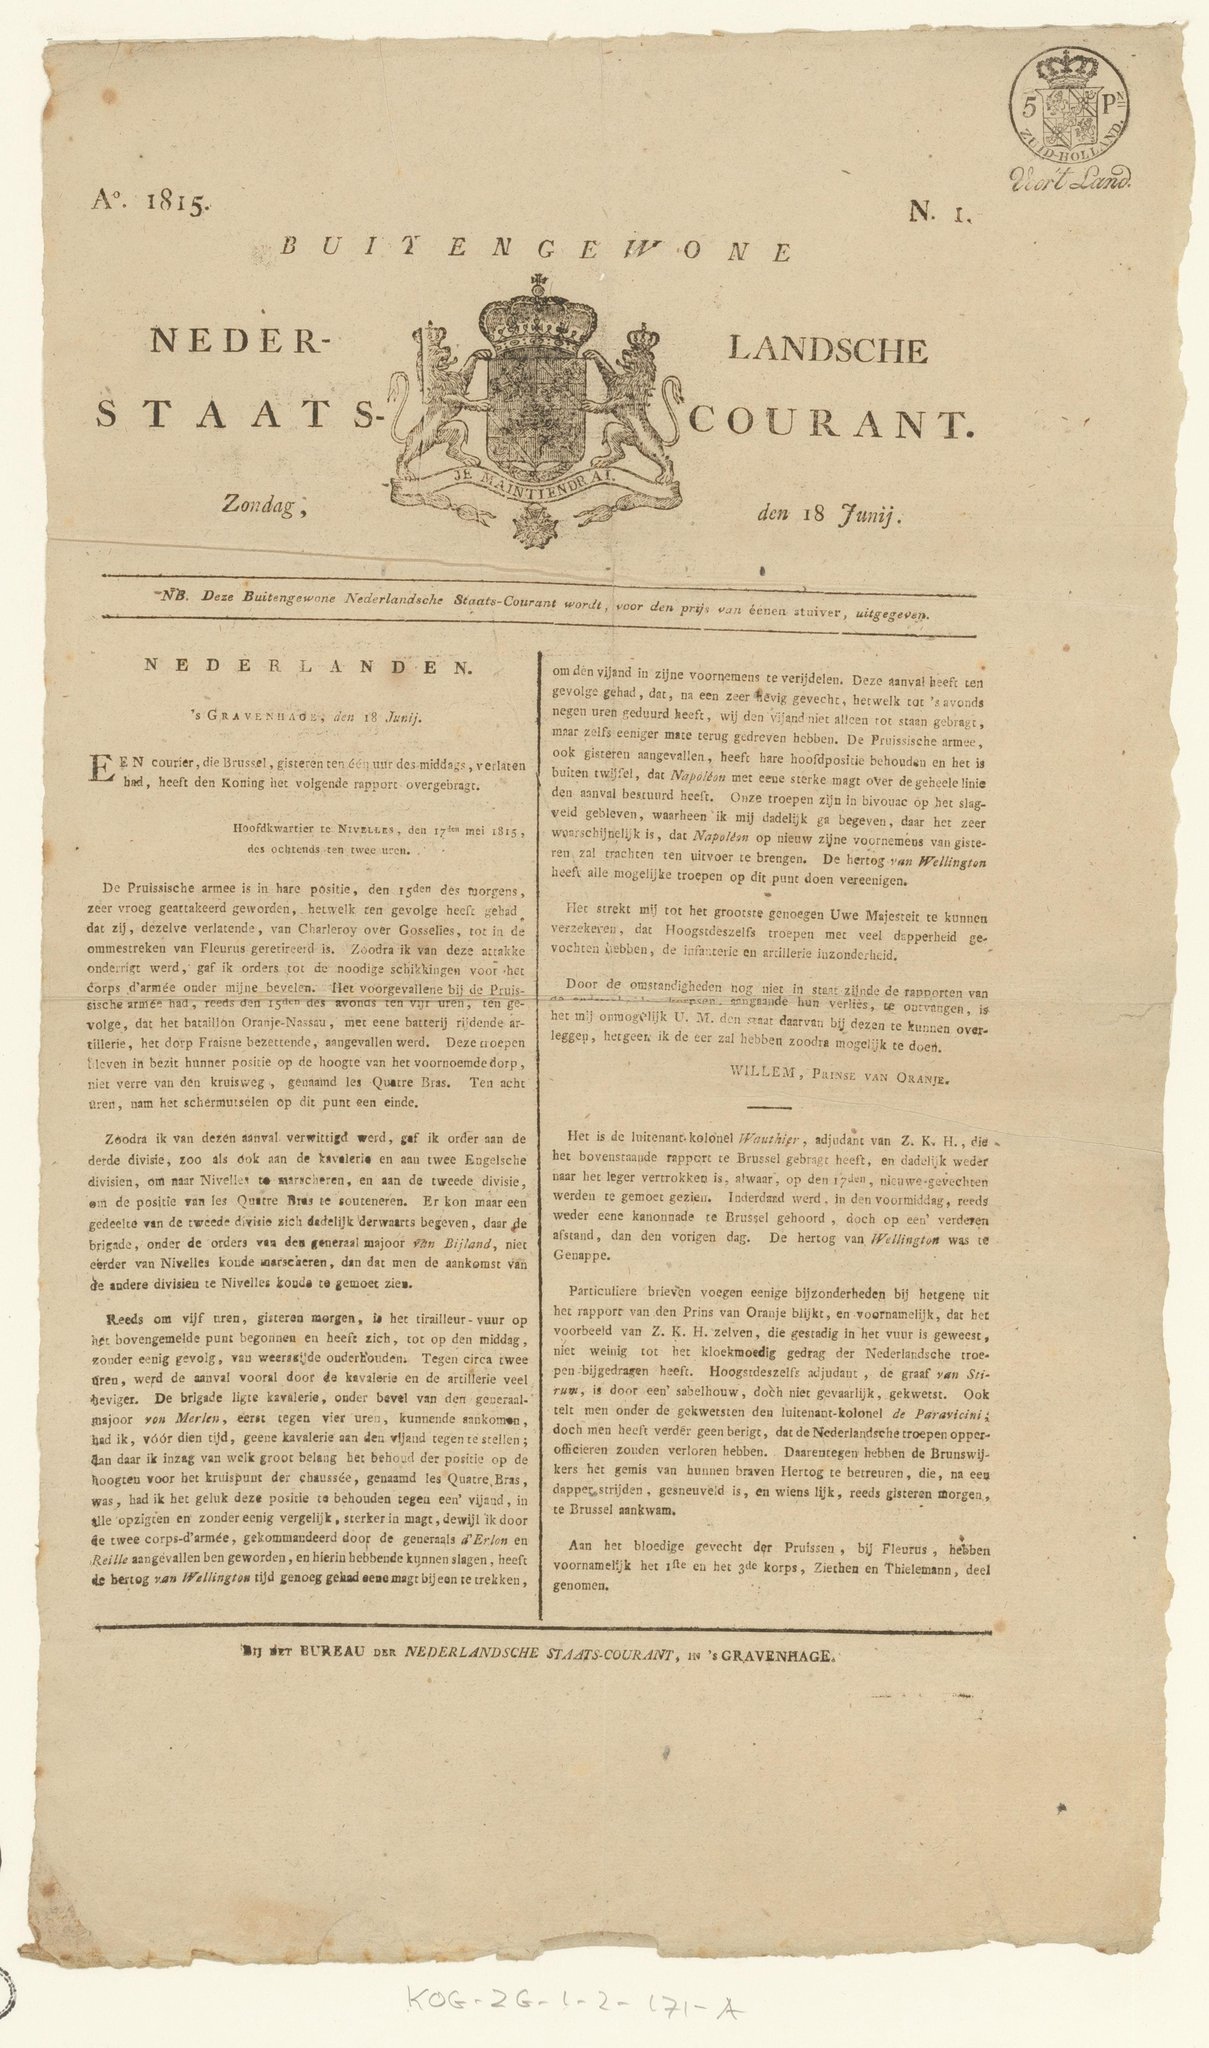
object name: newspaper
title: Buitengewone Nederlandsche Staatscourant, 18 juni 1815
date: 1815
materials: paper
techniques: letterpress printing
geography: the hague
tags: national government, newspaper, news-sheet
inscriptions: collector's mark, collector's mark: Lugt 1641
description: Exemplaar van de krant 'Buitengewone Nederlandsche Staatscourant' van 18 juni 1815 over de slag bij Waterloo. Gedrukte tekst met bovenaan het landswapen. Rechtsboven een stempel betaalde accijnzen. Onderwerpsrubrieken binnen de Atlas Zeden en Gewoonten: Regeering, Publicaties.